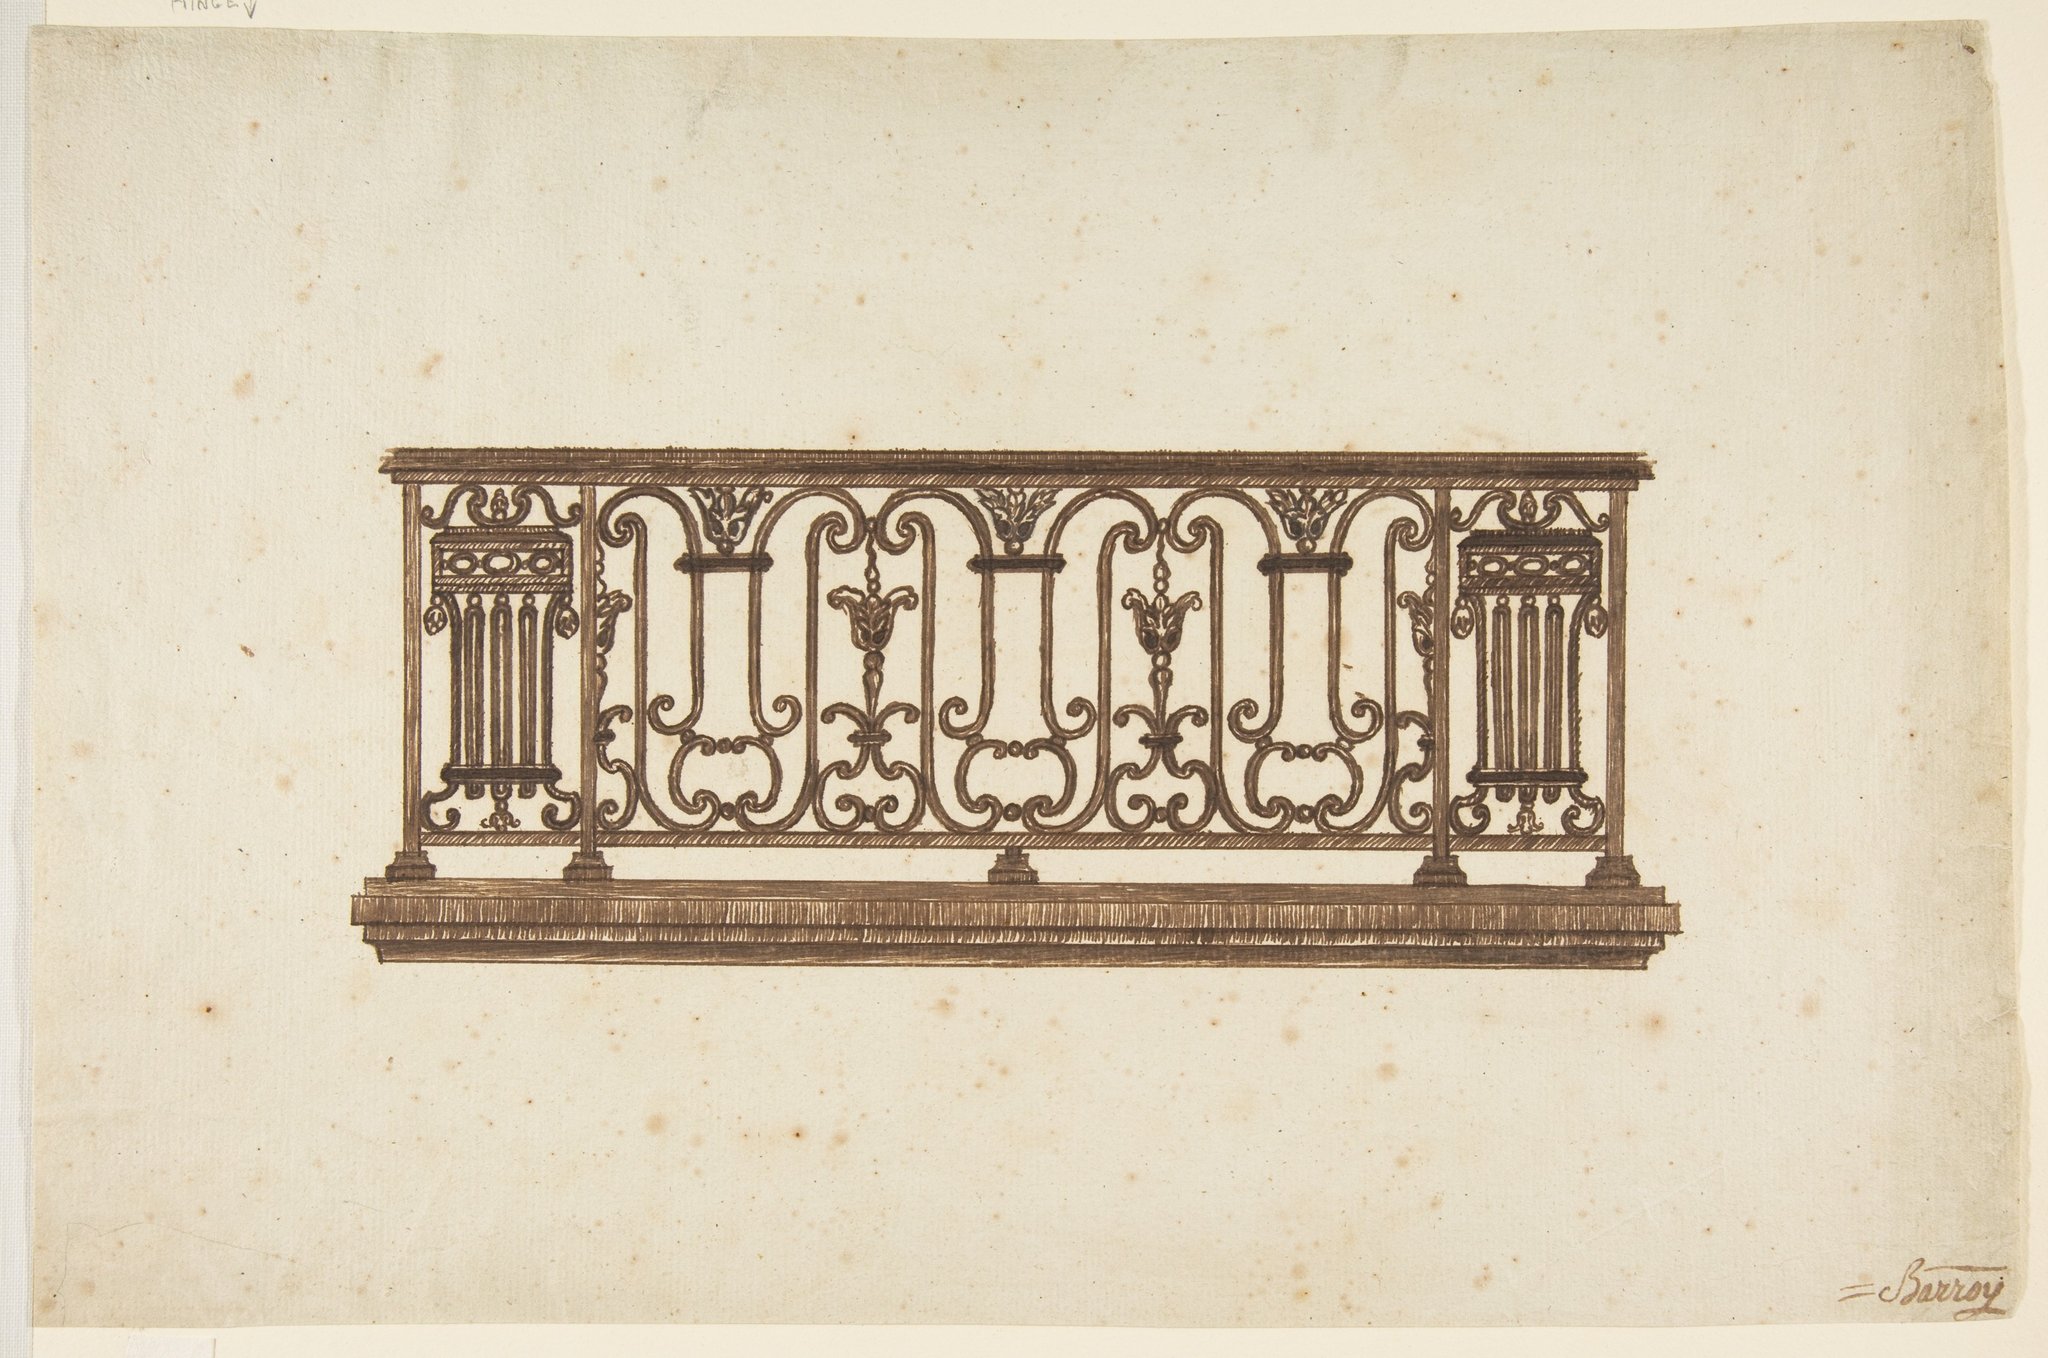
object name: drawing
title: Design for an Iron Railing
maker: anonymous, french, 18th century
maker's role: artist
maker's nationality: french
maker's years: 1700-1800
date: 1701-1800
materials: ink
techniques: brush, pen, wash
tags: architecture